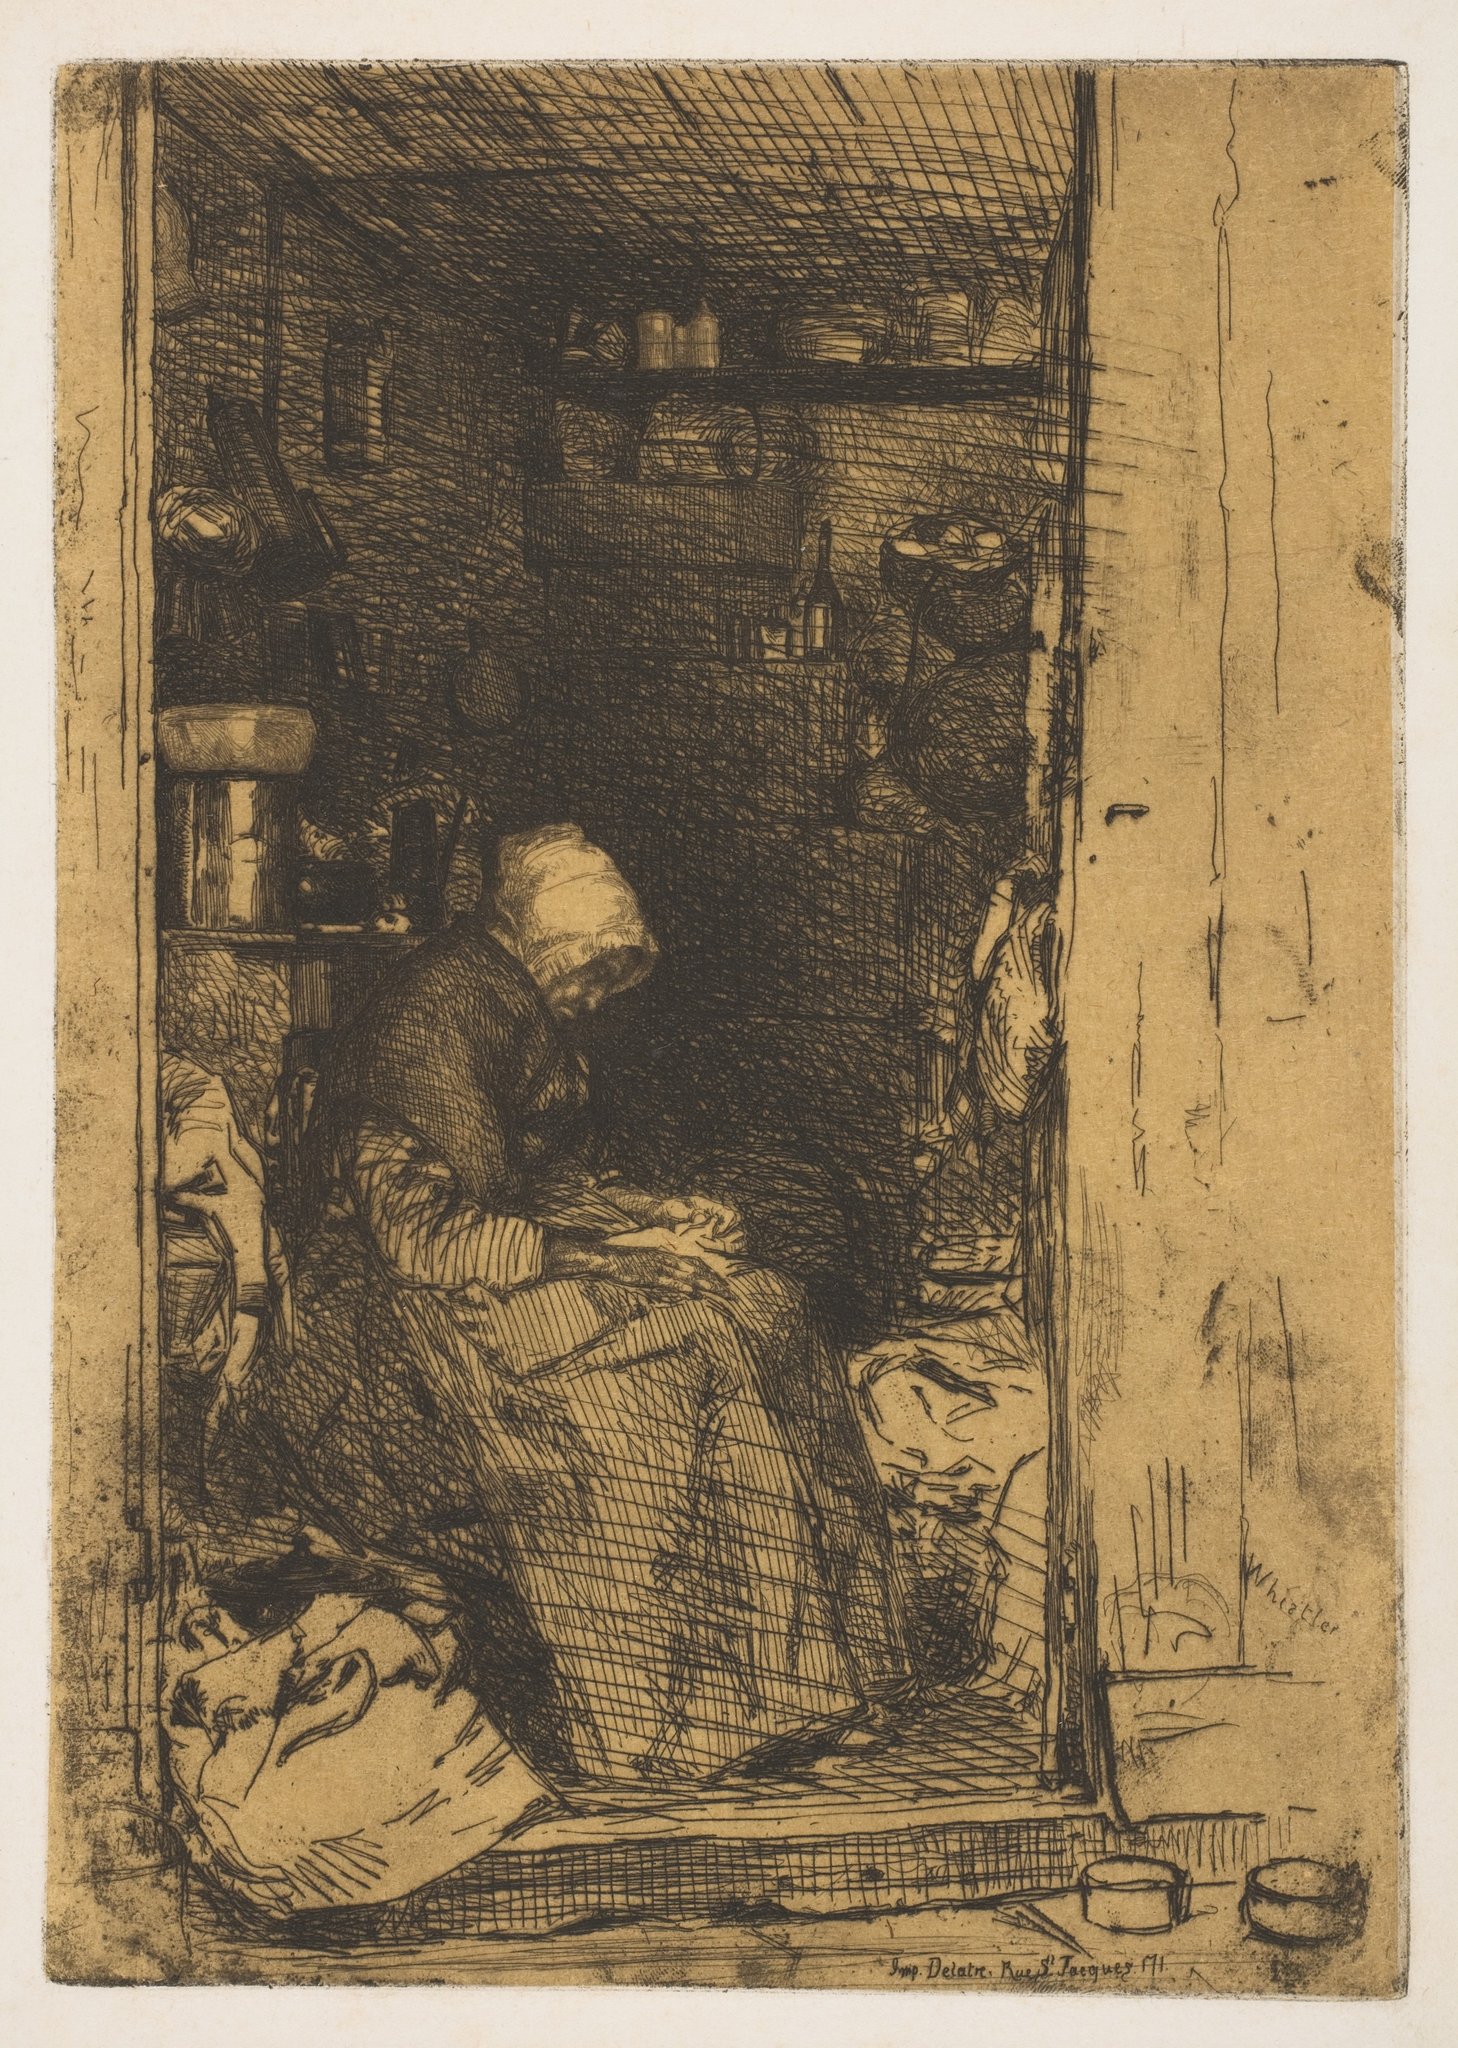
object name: print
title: La Vielle aux Loques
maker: james mcneill whistler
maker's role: artist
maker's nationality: american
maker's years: 1834-1903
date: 1858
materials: chine, paper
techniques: printmaking, drypoint, etching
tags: women